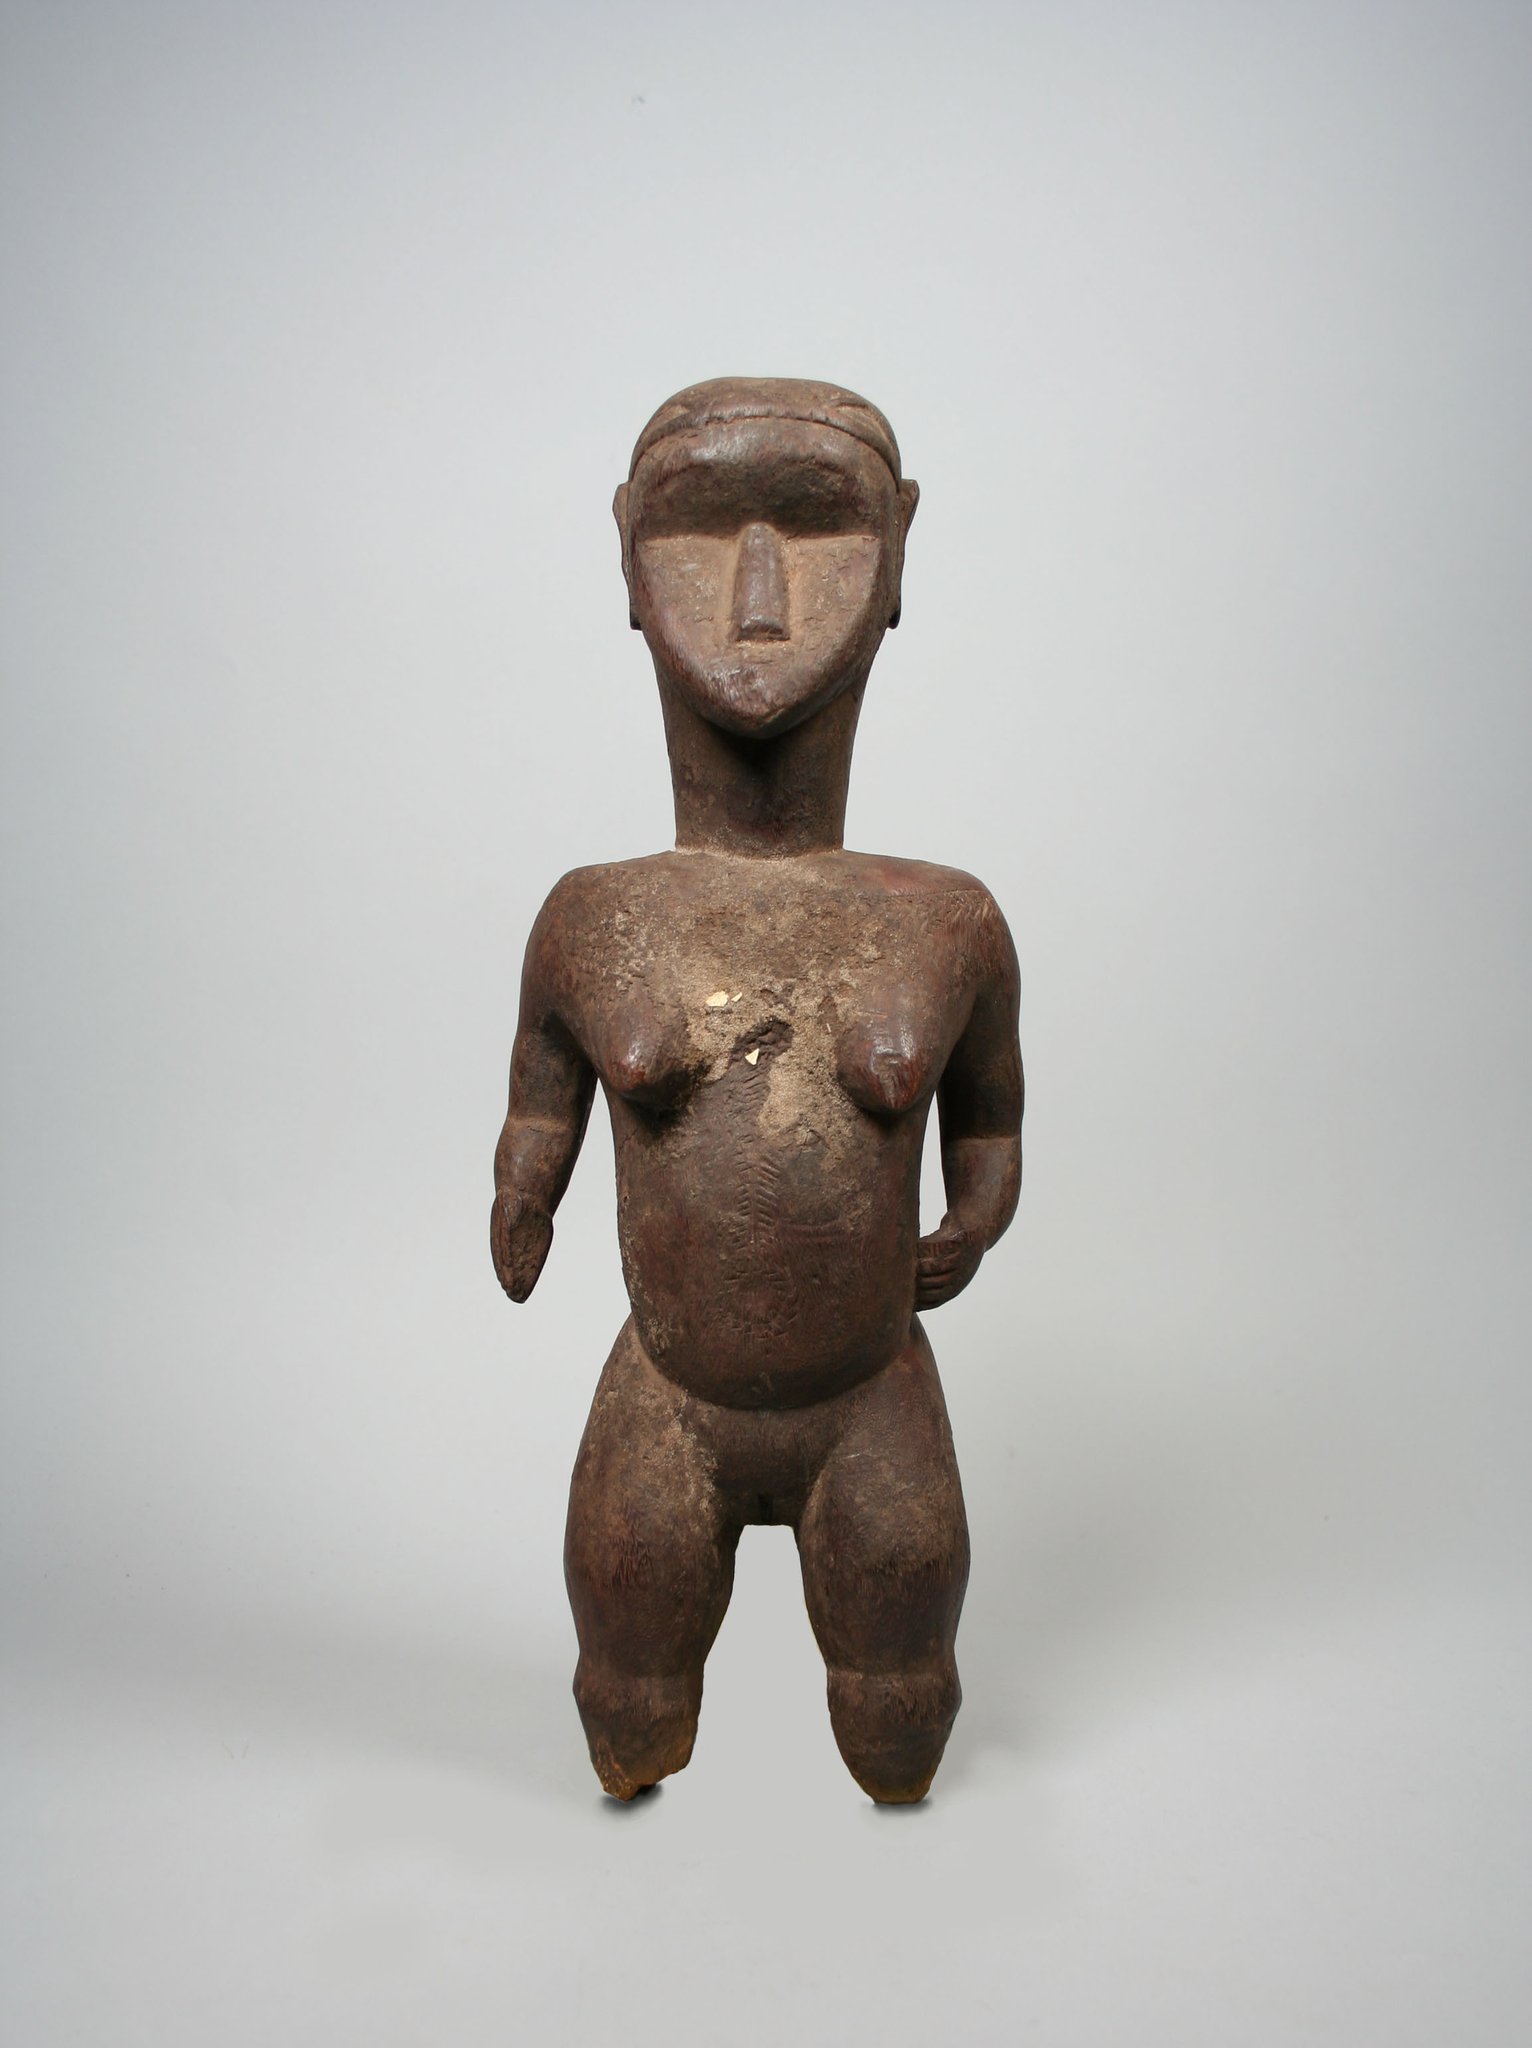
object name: figure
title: Figure: Female (Neganou)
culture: bidjogo peoples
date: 1801-1900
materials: wood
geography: guinea bissau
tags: female nudes